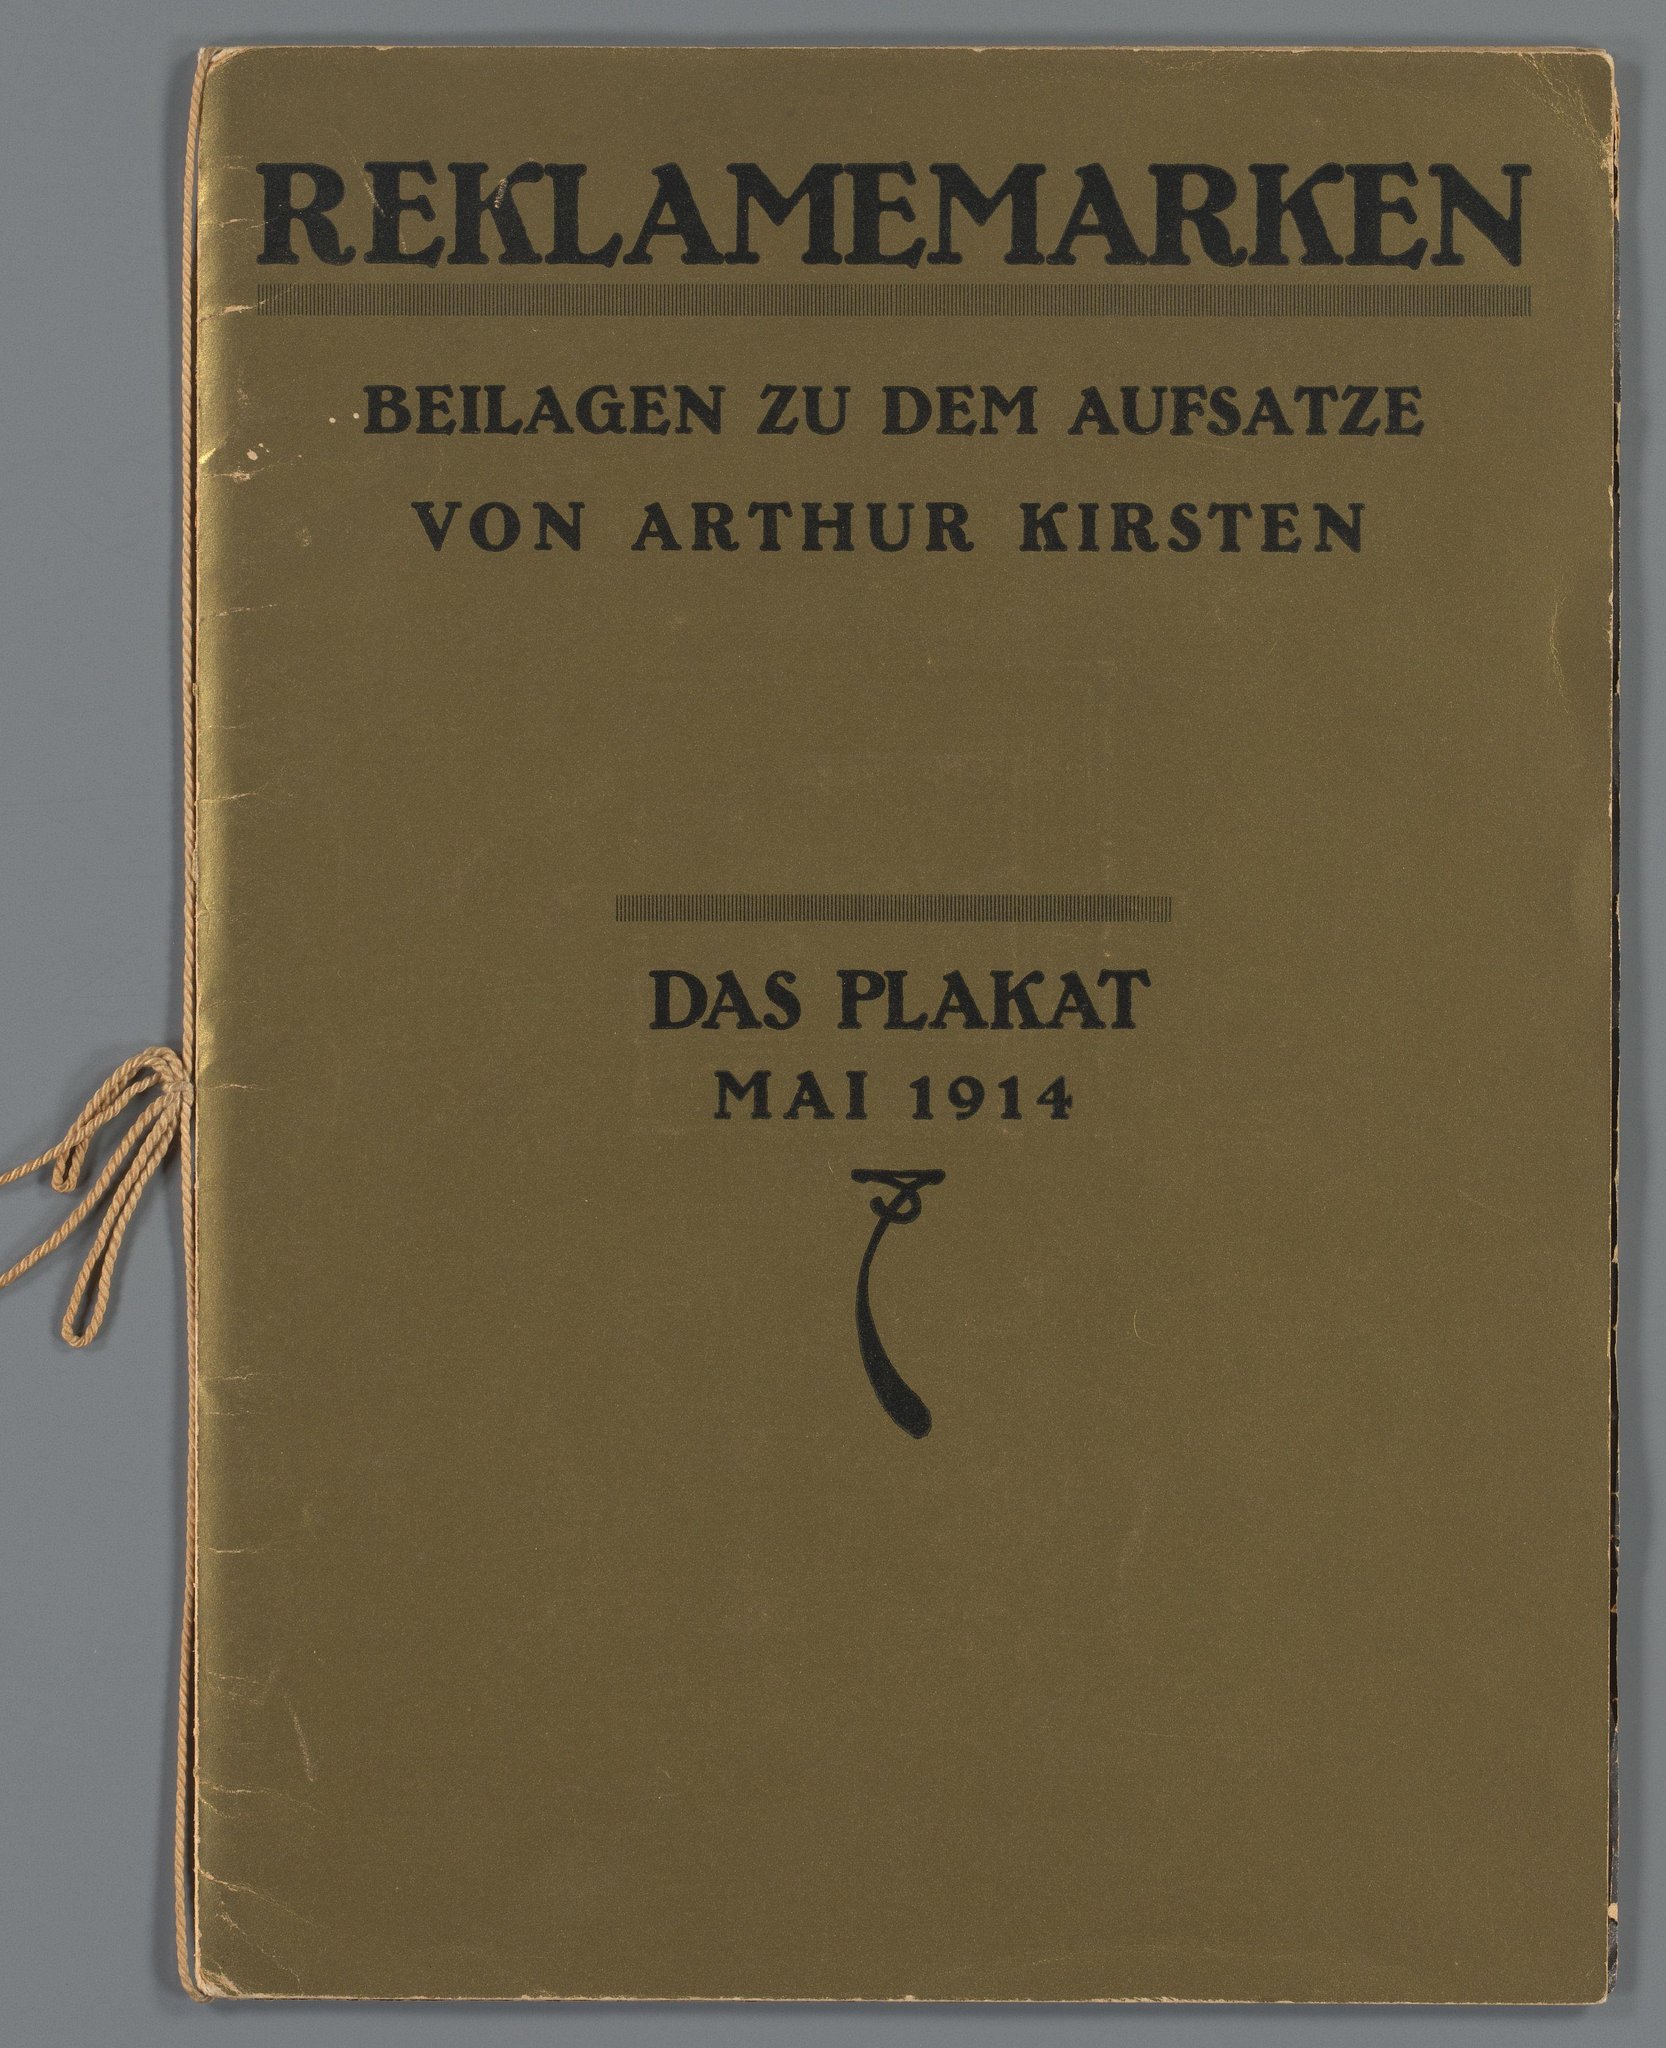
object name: album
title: Reklamemarken / Beilagen zu dem Aufsatze von Arther Kirsten / Das Plakat Mai 1914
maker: arthur kirsten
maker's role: schrijver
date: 1905-1914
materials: paper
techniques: lithograph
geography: berlin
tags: trade mark, trade token, trade sign, trade card, germany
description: Album bestaande uit drie gevouwen en gebonden bladen. Op elke bladzijde zijn Duitse sluitzegels, reclamezegels geplakt, met vermelding van de naam van de ontwerper. In een omslag van goudpapier. Verschenen als bijlage bij het tijdschrift Das Plakat, mei 1914.